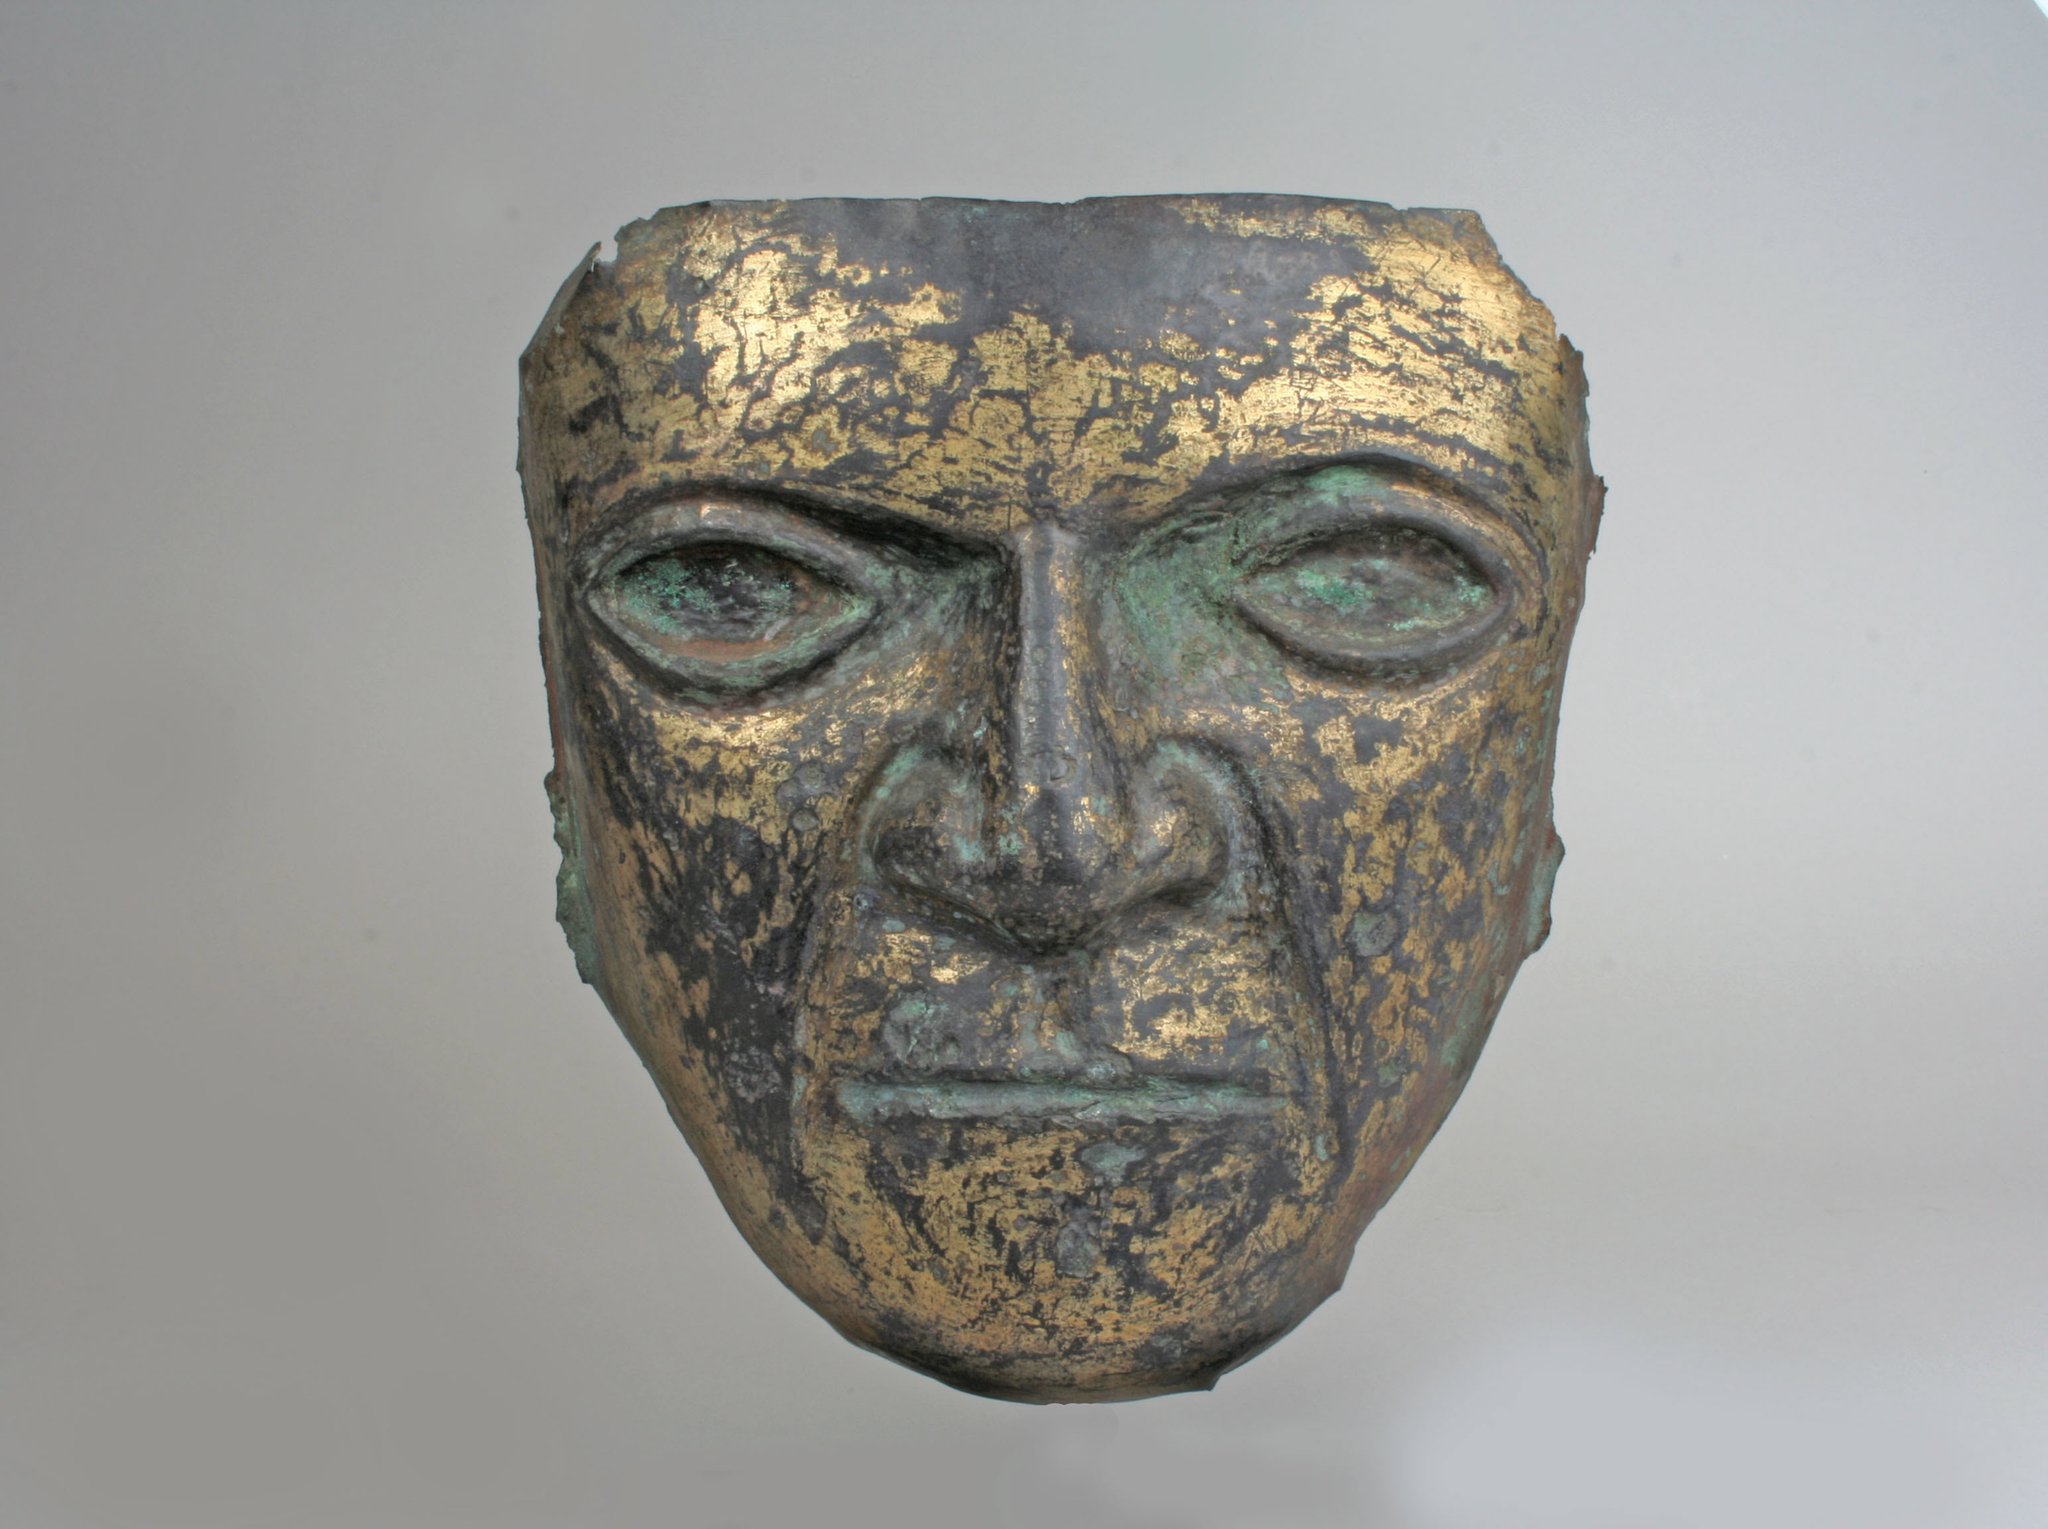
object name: mask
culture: moche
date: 100 BCE-700 CE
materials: copper, gilt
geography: peru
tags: faces